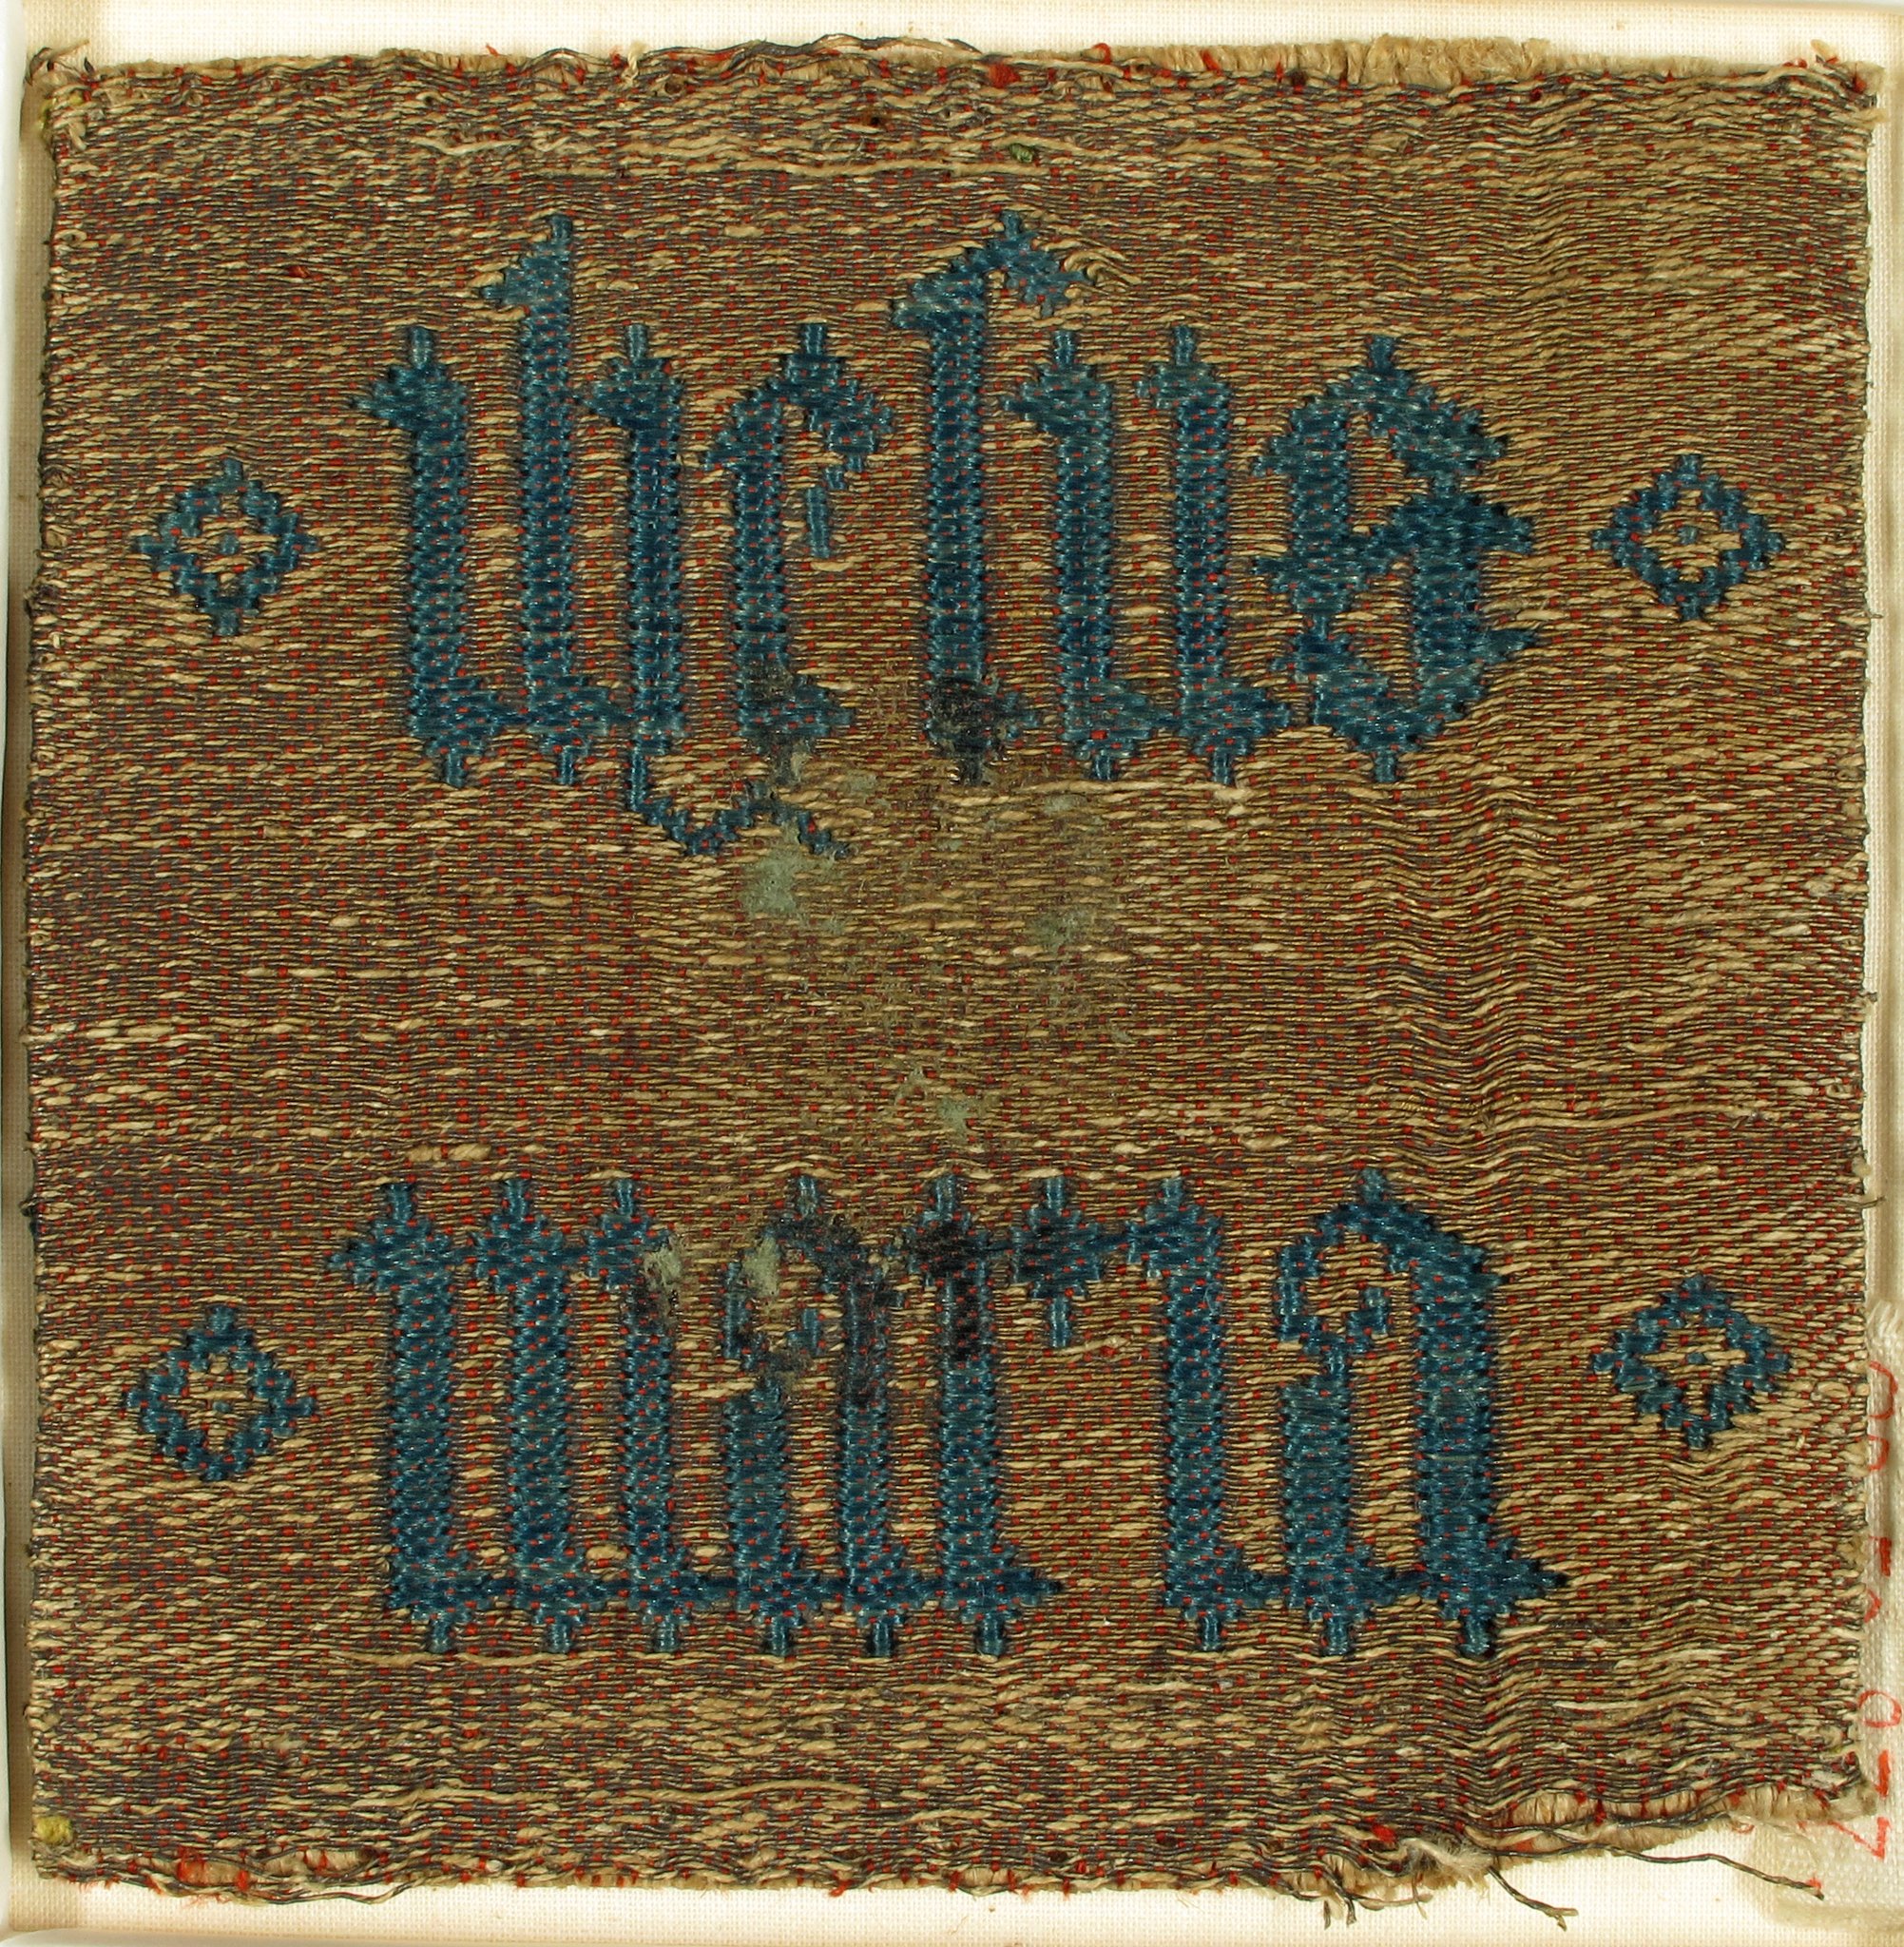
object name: textile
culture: german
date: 1401-1500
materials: linen, metal thread, silk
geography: germany